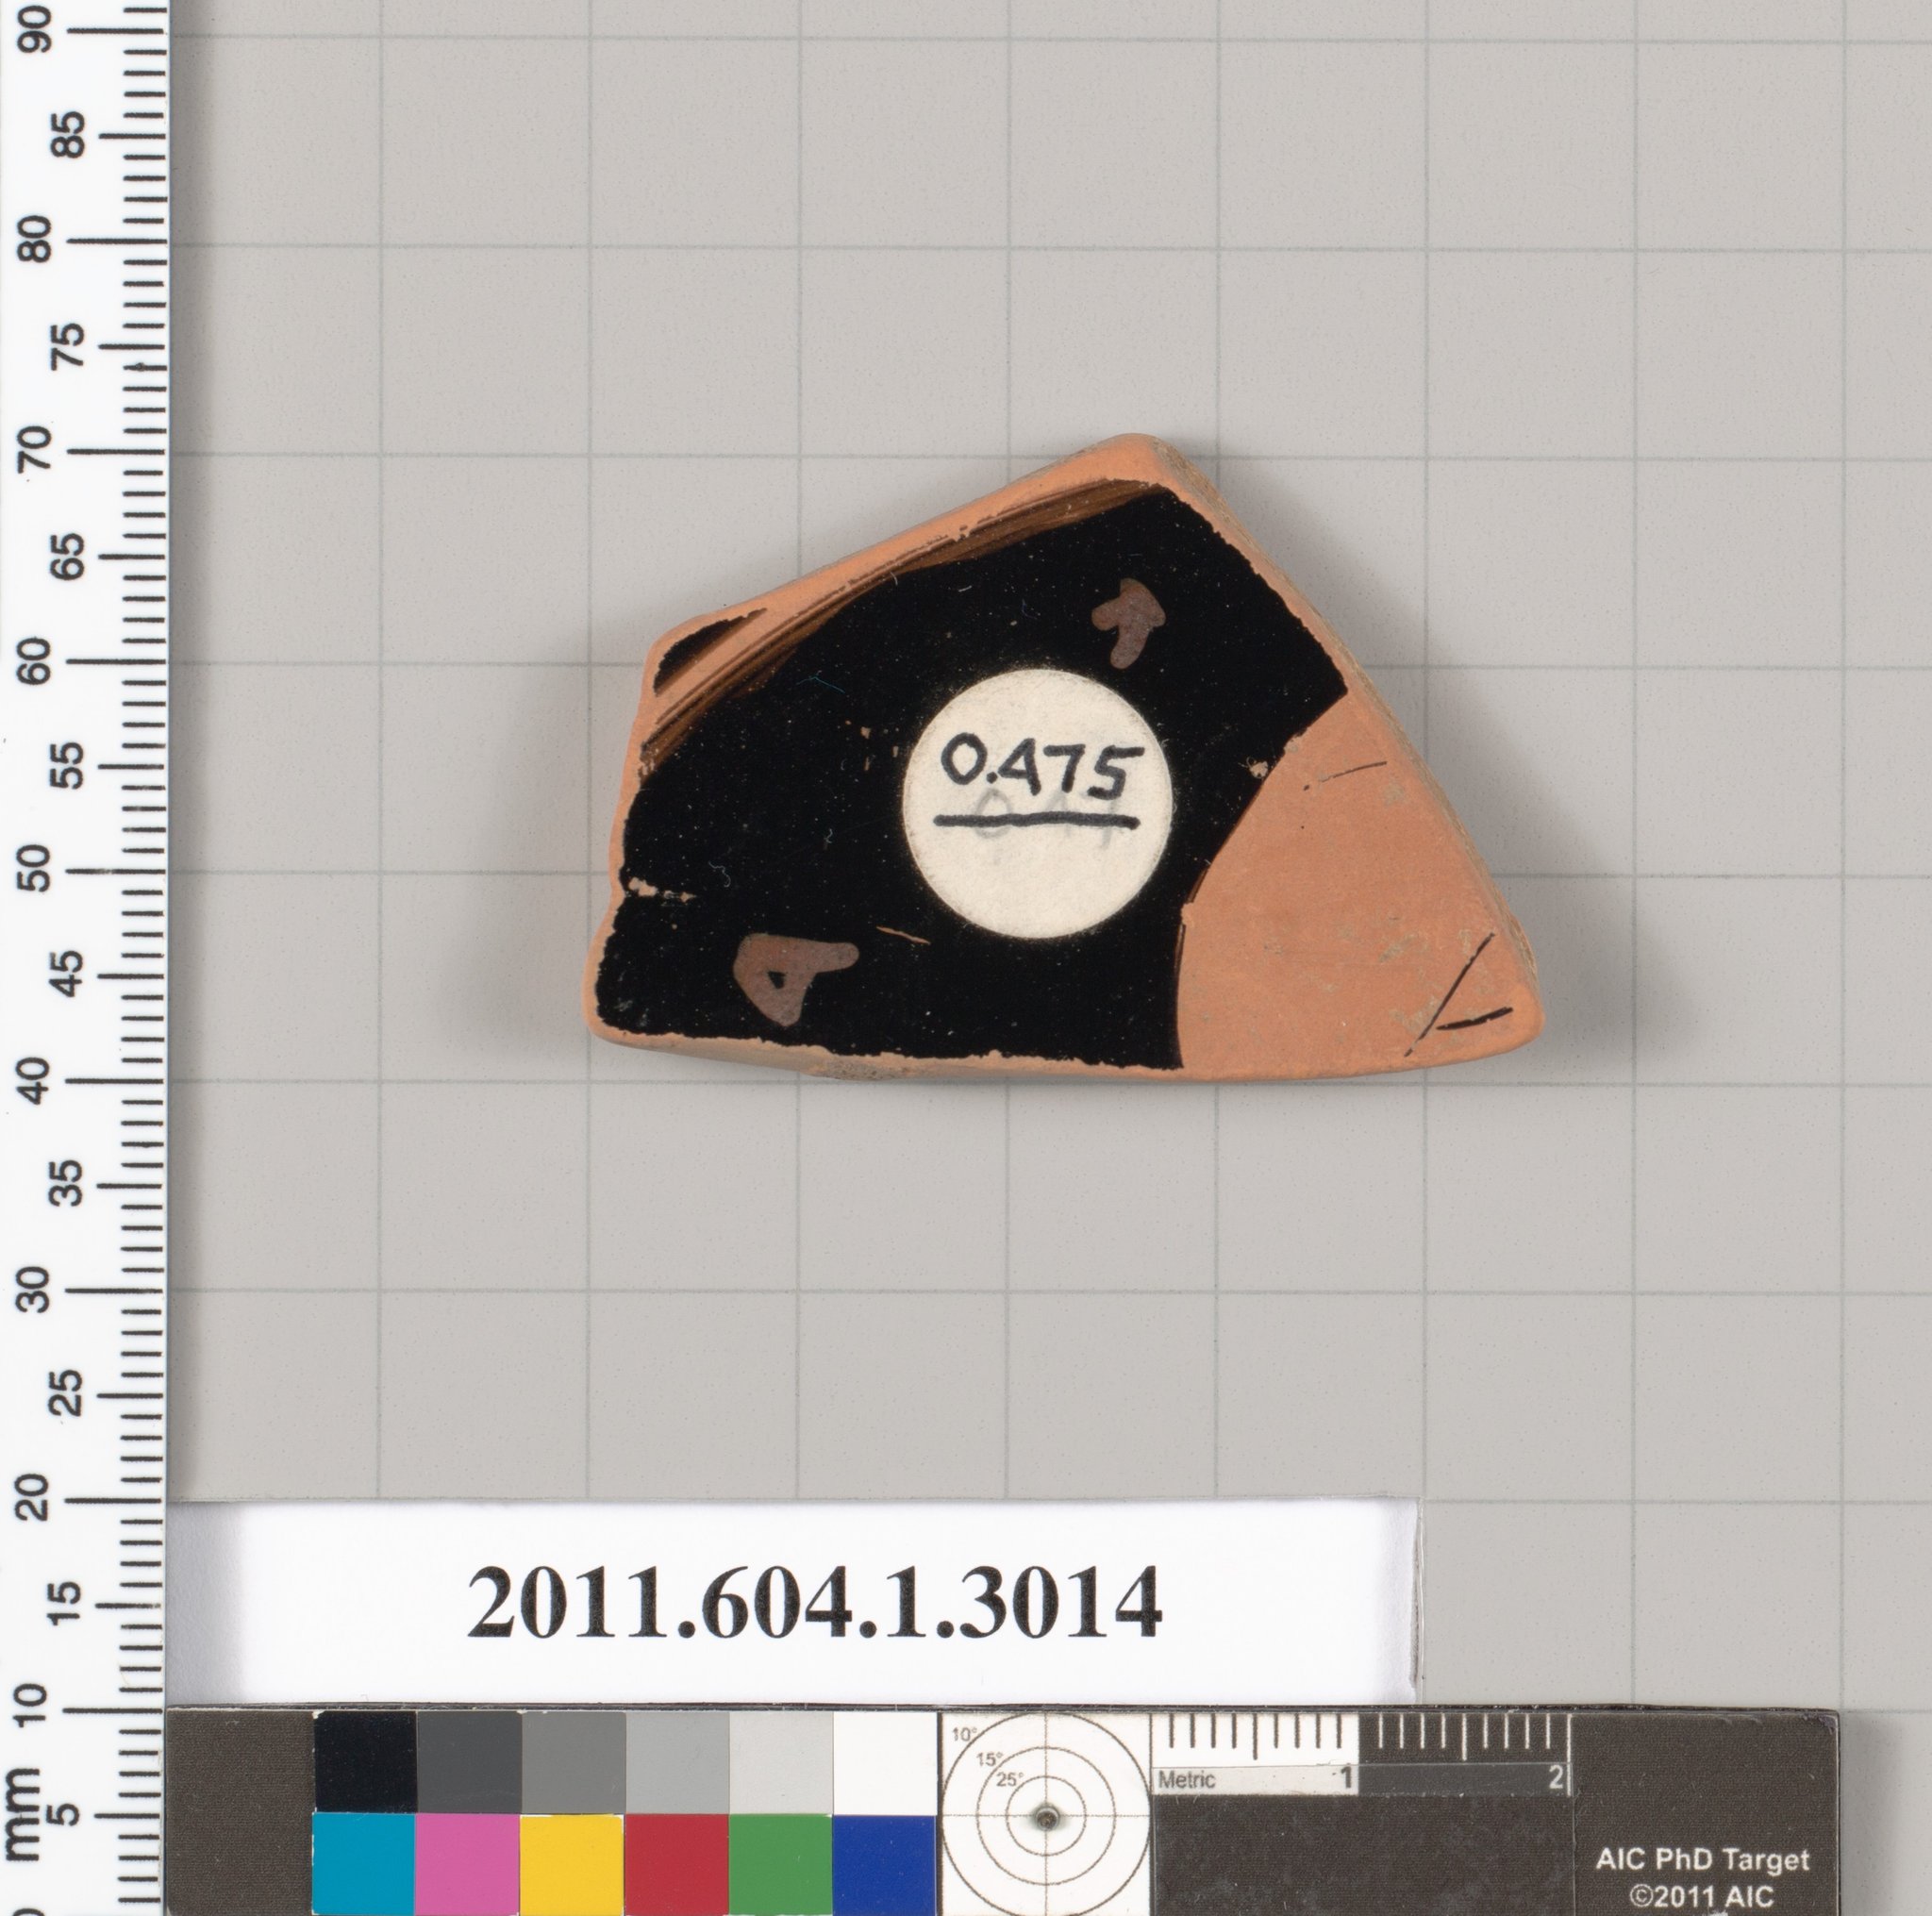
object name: kylix fragment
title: Terracotta fragment of a kylix (drinking cup)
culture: greek, attic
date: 520-500 BCE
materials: terracotta